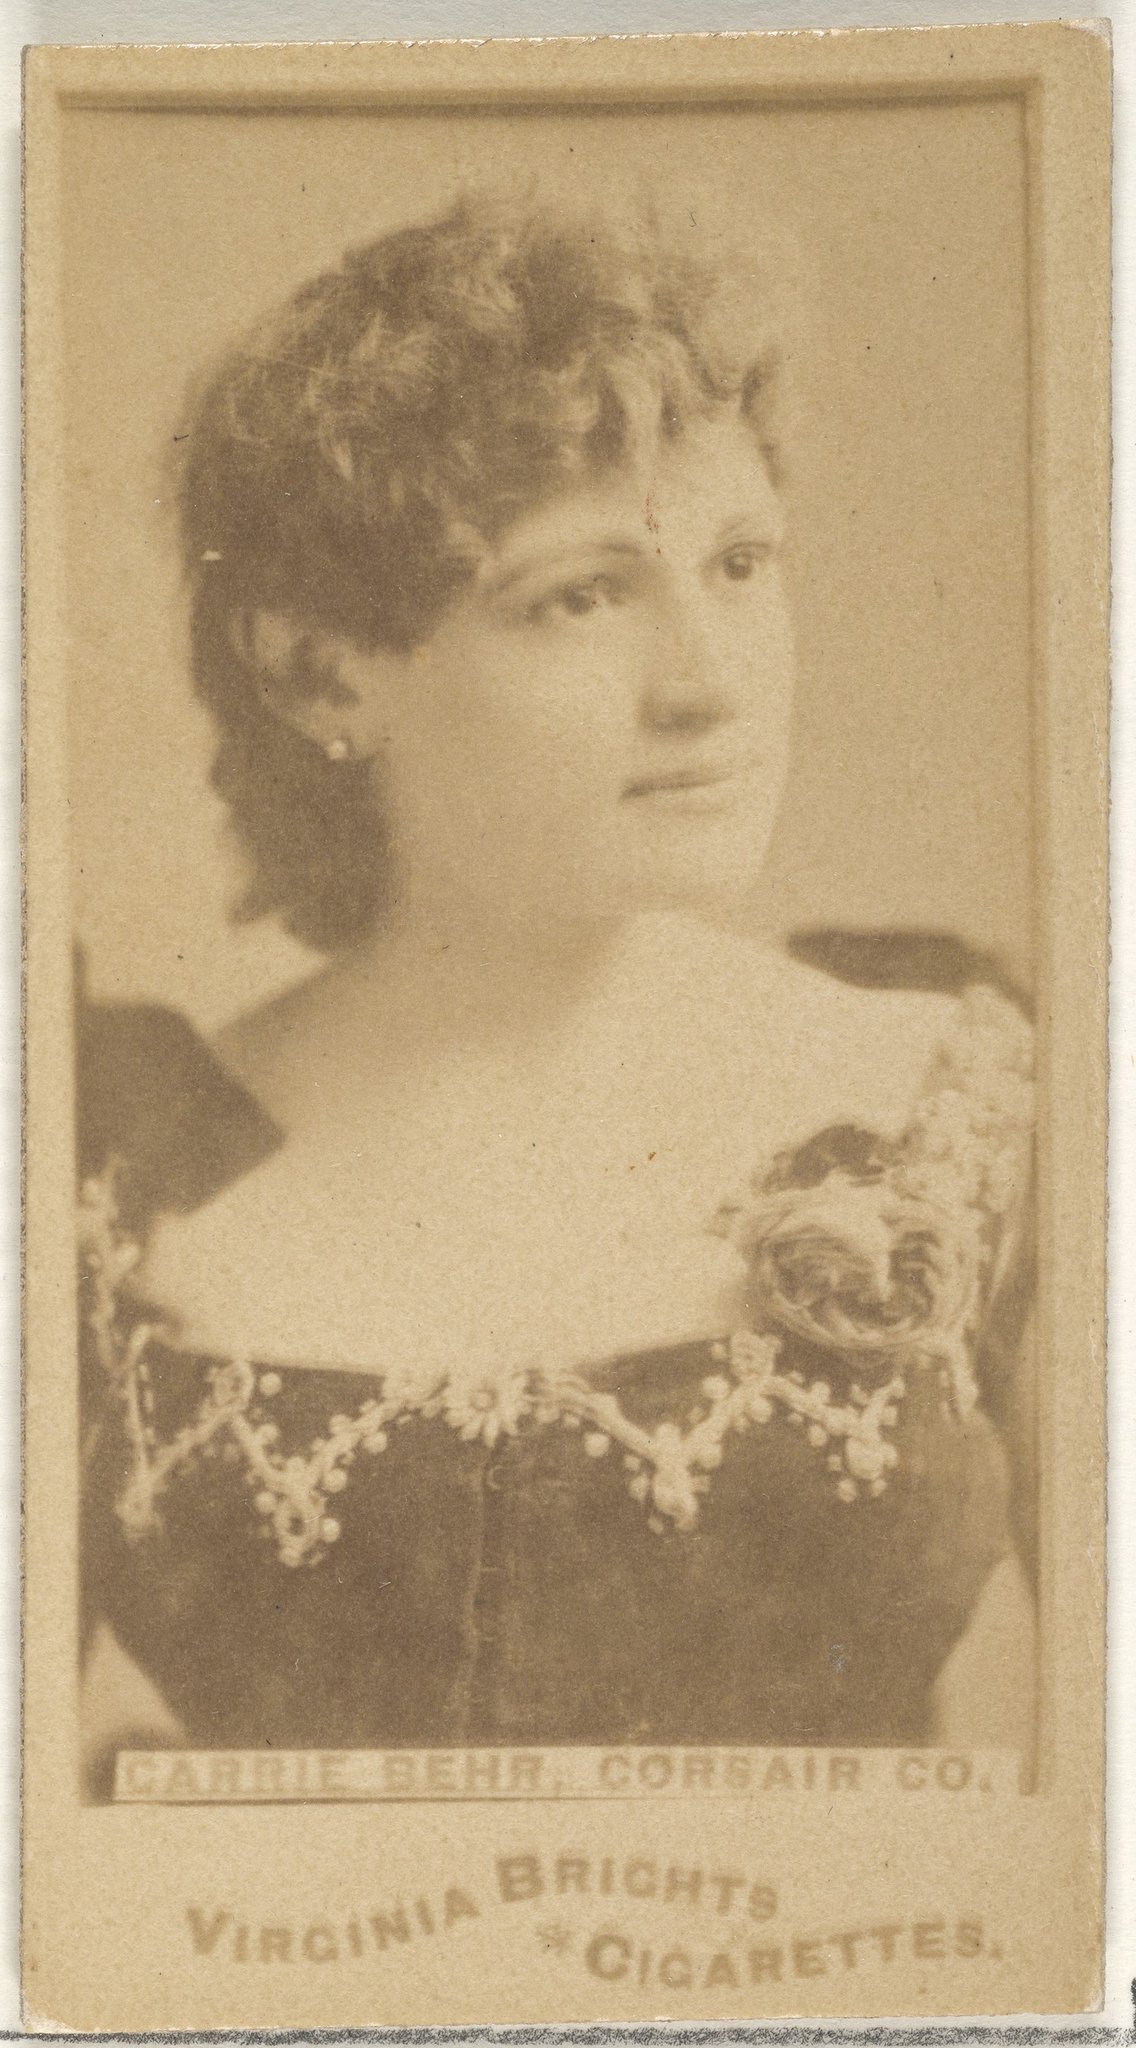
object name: photograph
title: Carrie Behr, Corsair Co., from the Actors and Actresses series (N45, Type 1) for Virginia Brights Cigarettes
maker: allen & ginter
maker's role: publisher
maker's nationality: american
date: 1888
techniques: albumen silver print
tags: portraits,women,actresses